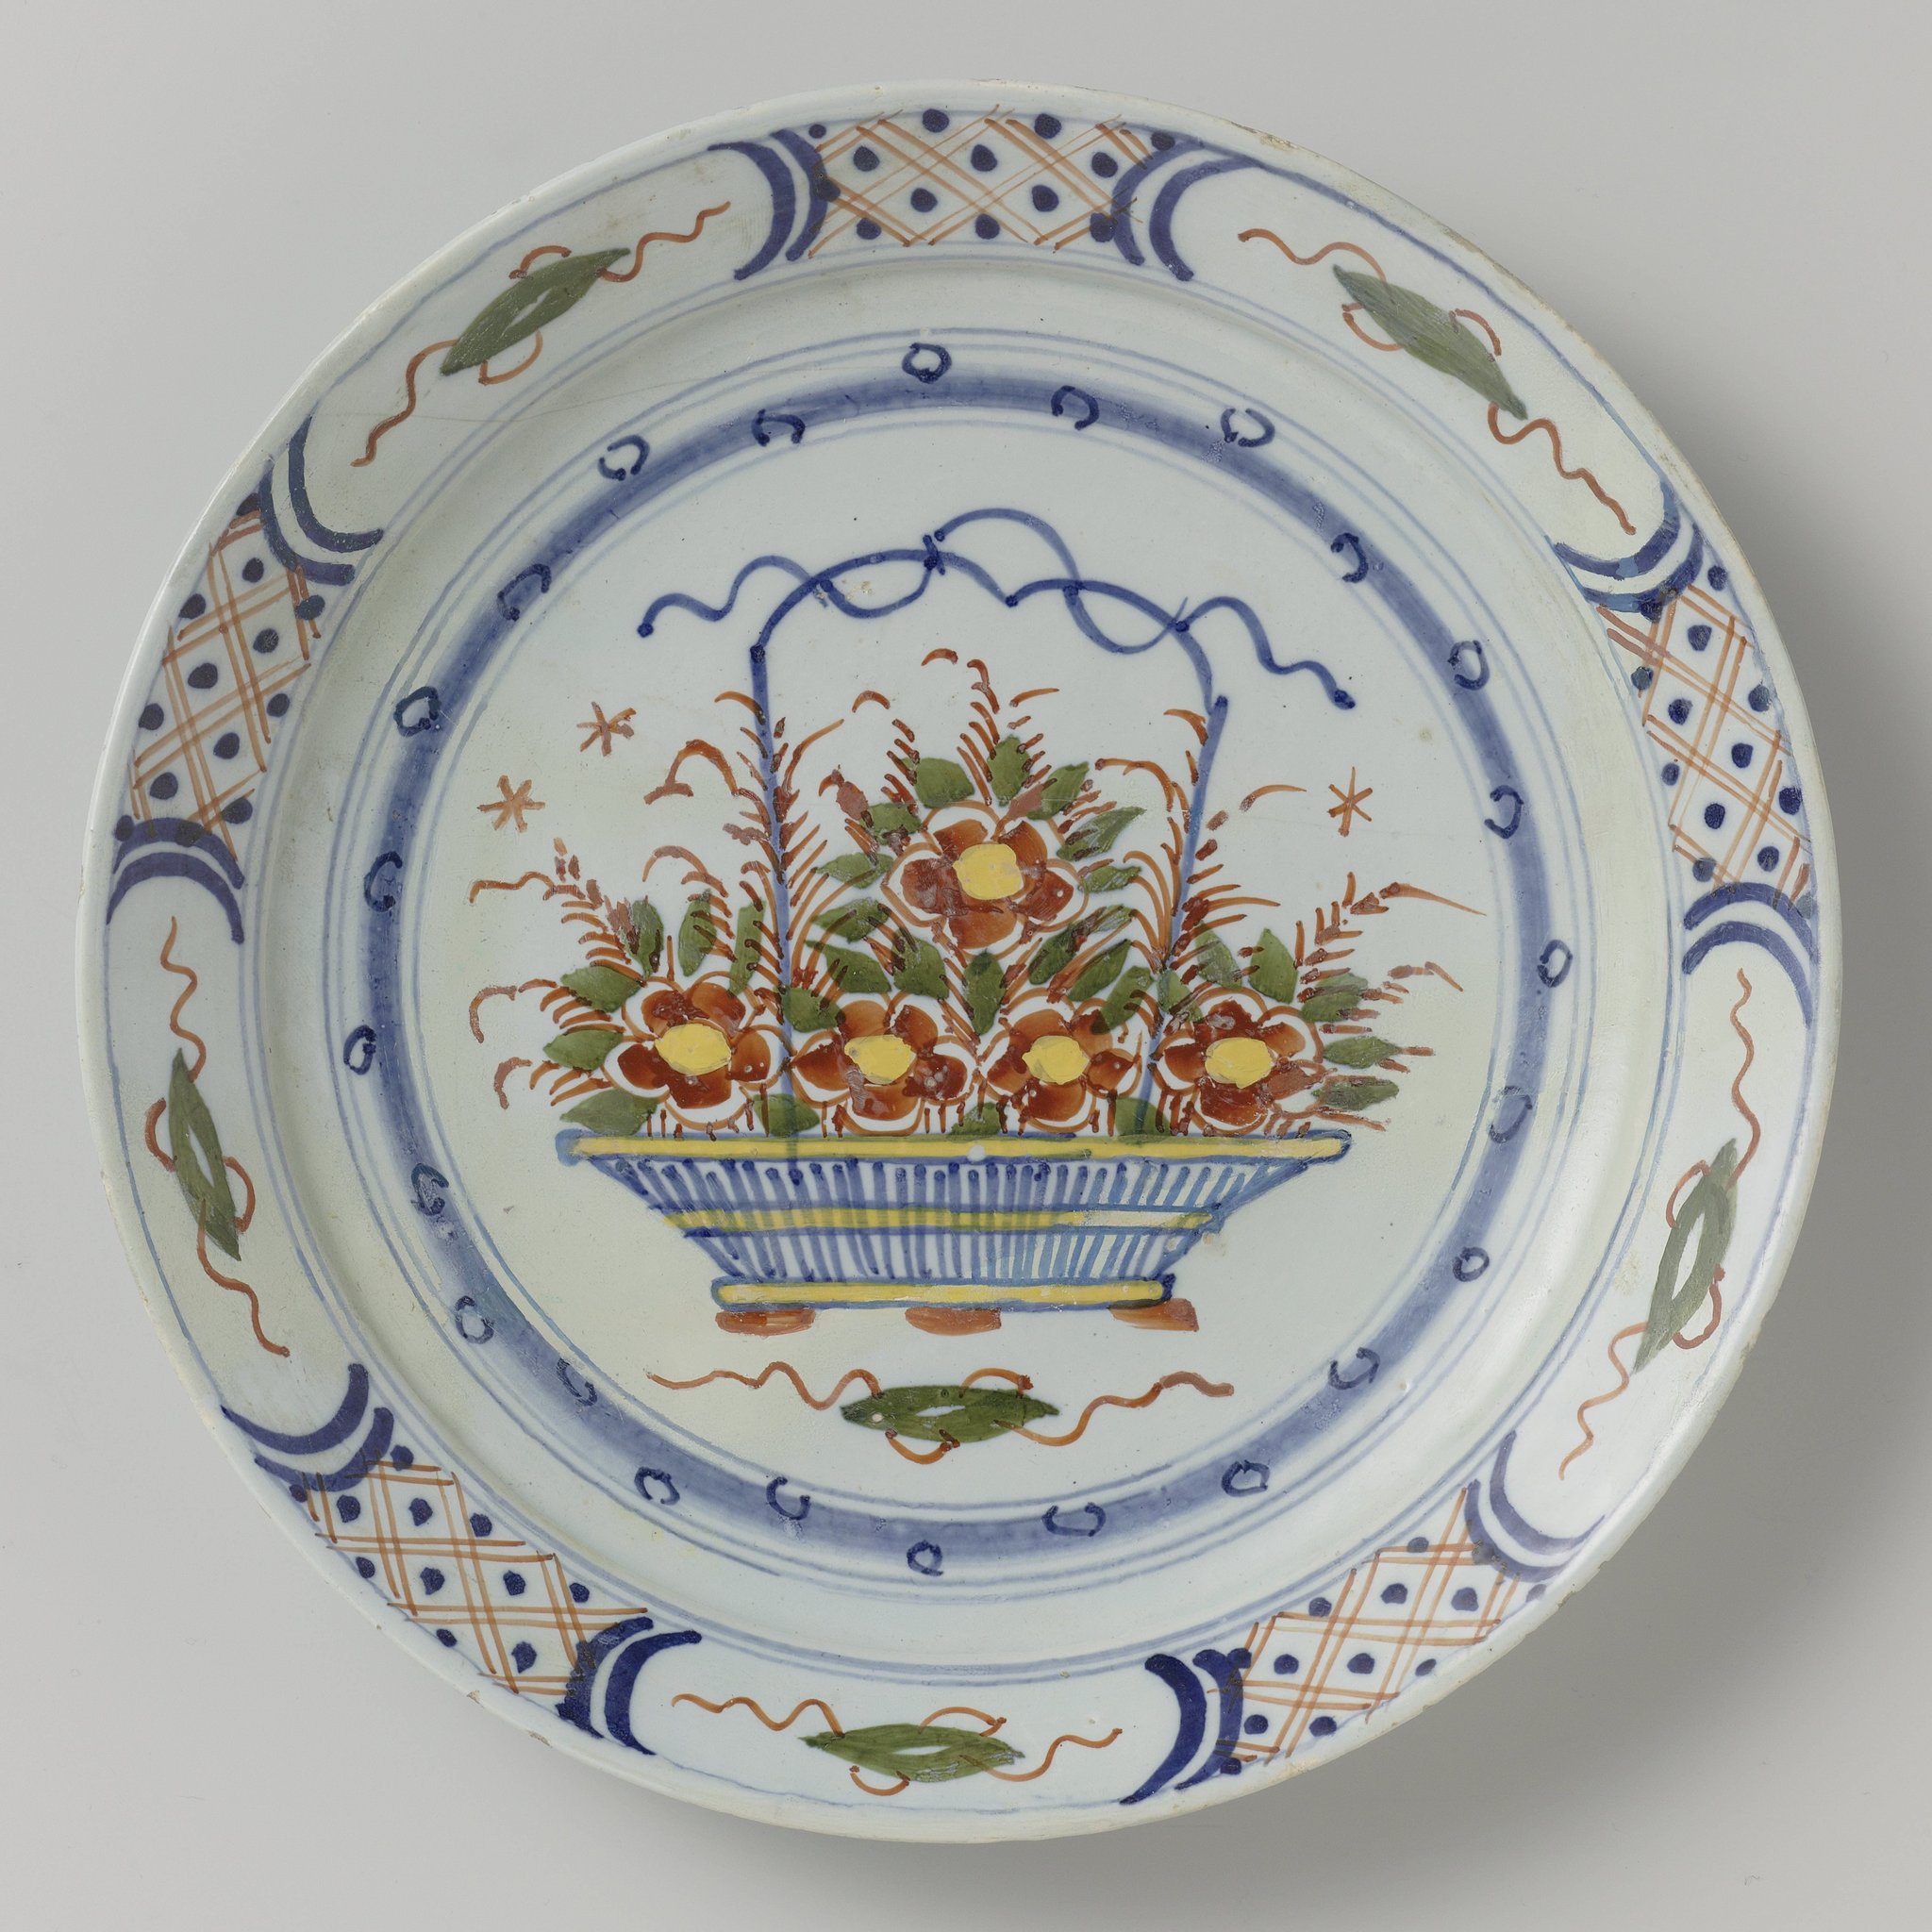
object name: plate dish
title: bord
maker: Anonymous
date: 1740-1780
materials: earthenware, glaze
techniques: painted, polychromy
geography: delft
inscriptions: collector's mark: ‘koninklijk oudheidkundig genootschap no. 46’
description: Rond bord van veelkleurig beschilderde faience, met op het plat een mand met bloemen in de kleuren blauw, groen, geel en rood en op de rand een veelkleurig Chinees motief. Bij het bord horen vier identieke borden met de invnrs. BK-KOG-2428-a, BK-KOG-2428-b, BK-KOG-2428-d en BK-KOG-2428-e.